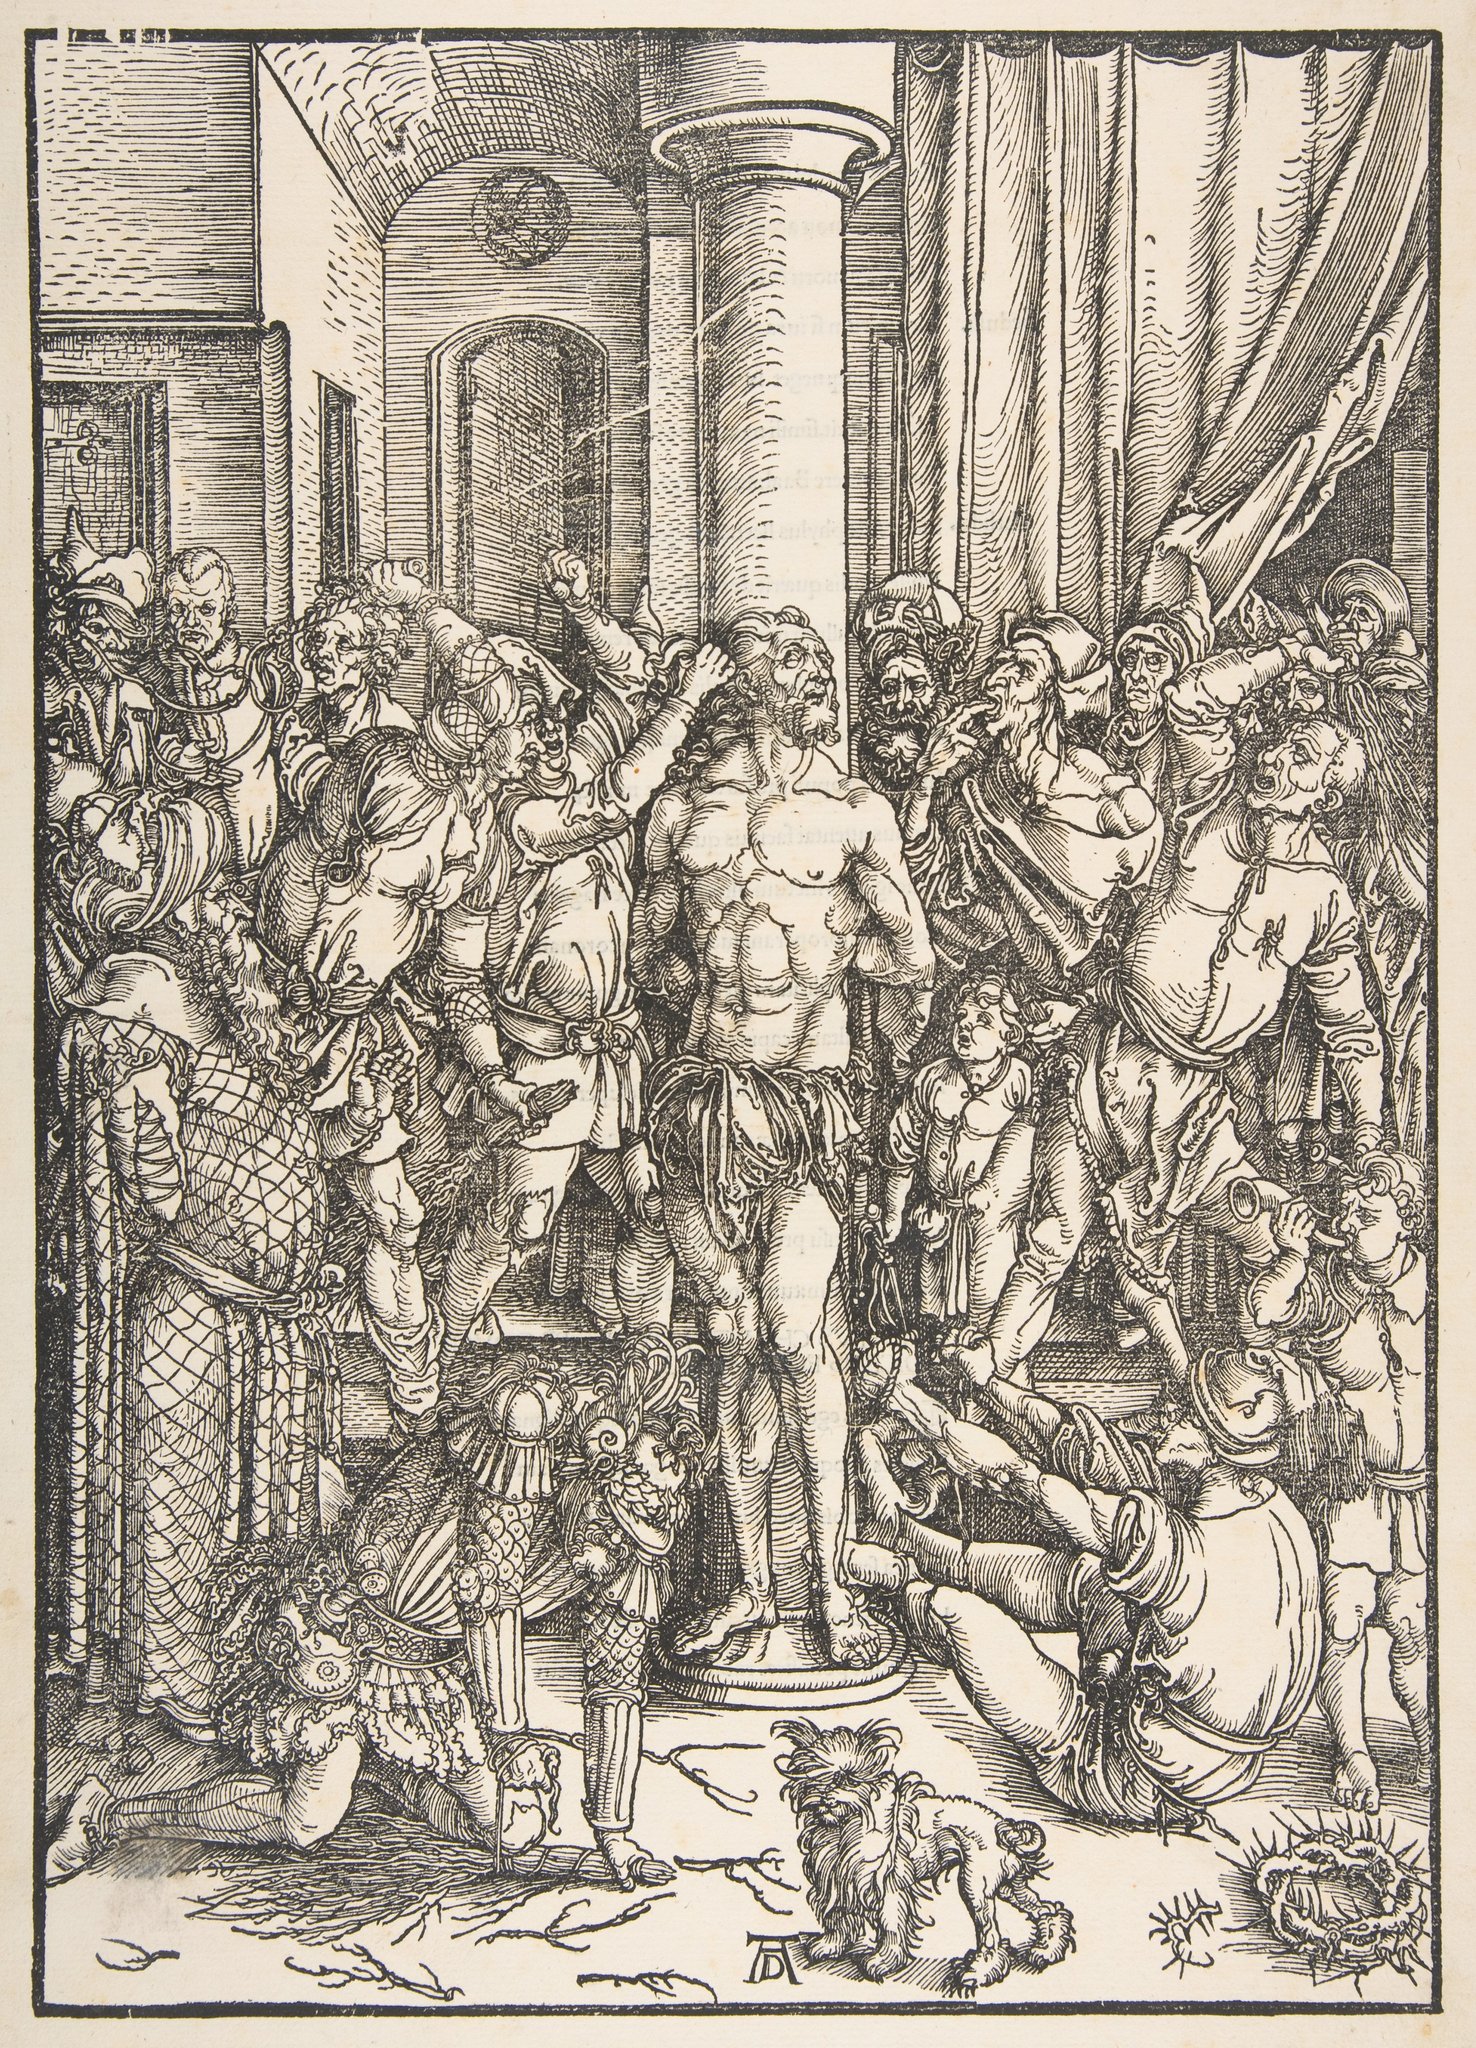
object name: print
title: The Flagellation, from "The Large Passion"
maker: albrecht dürer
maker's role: artist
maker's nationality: german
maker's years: 1471-1528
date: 1511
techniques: woodcut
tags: columns,men,dogs,christ